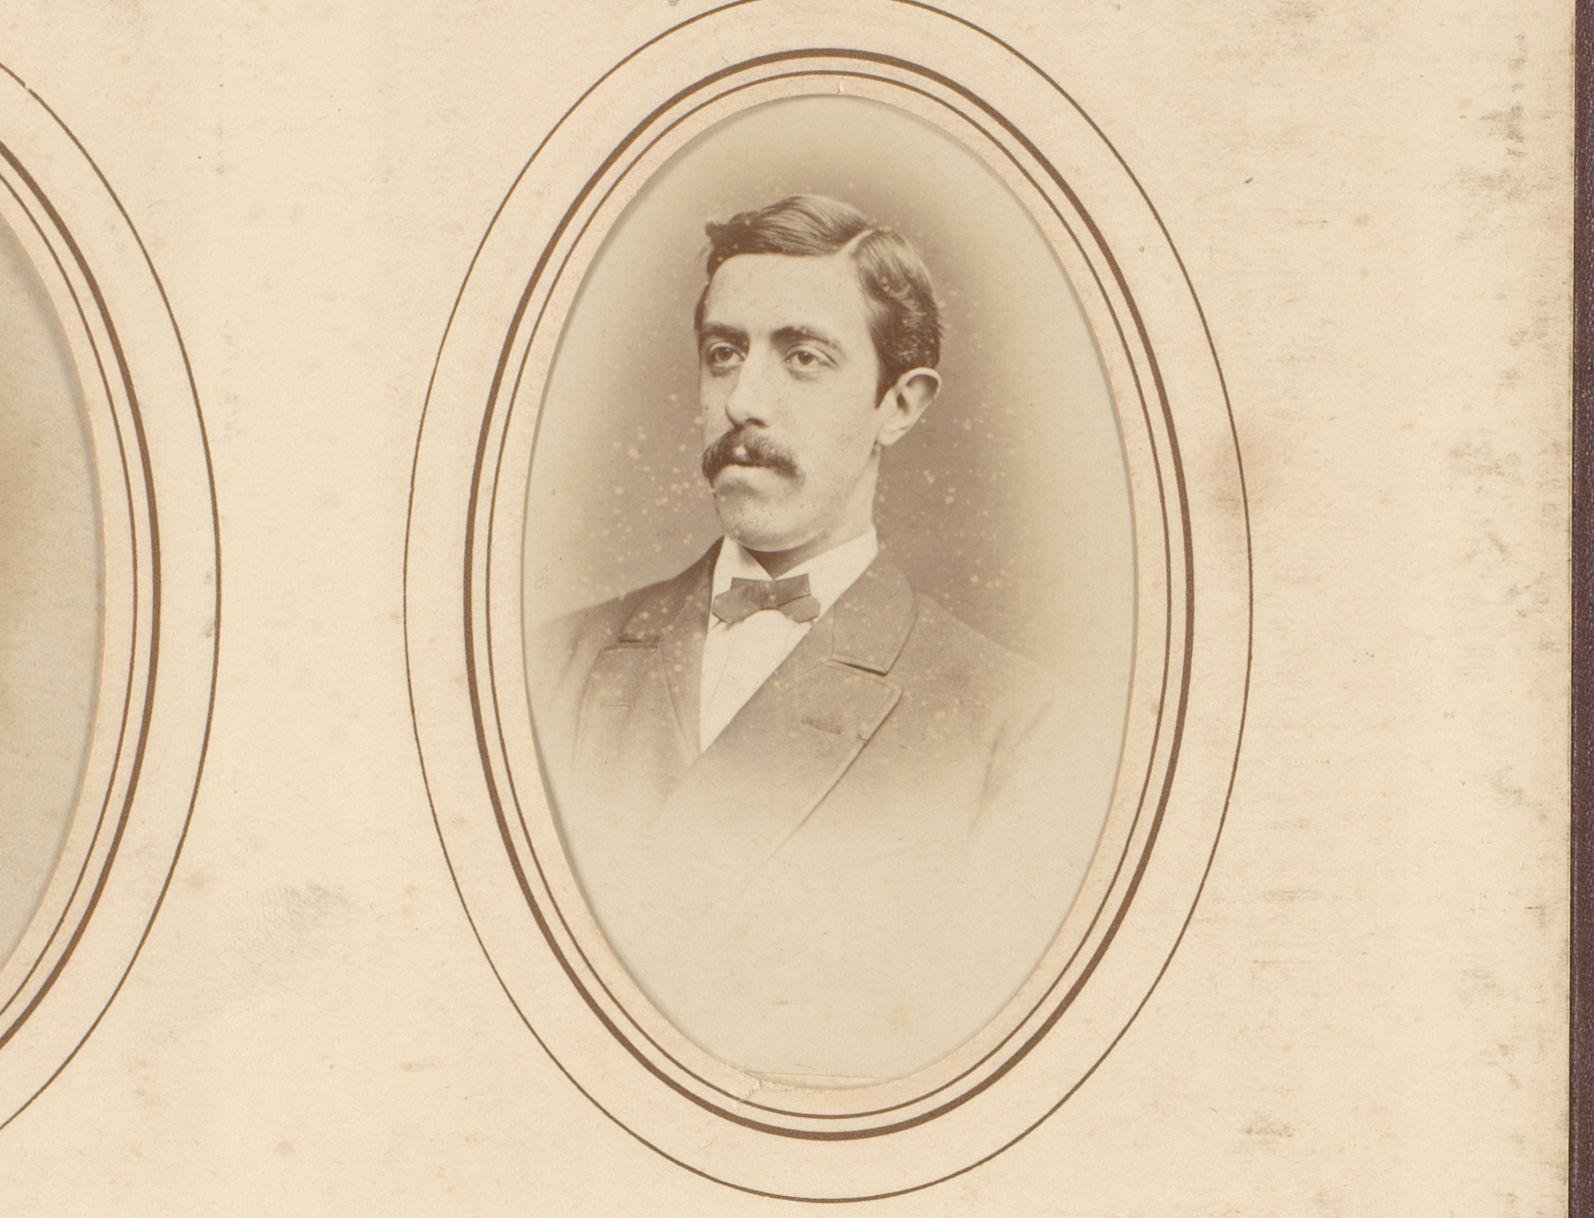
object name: album leaf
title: Portret van een man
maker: george lodewijk mulder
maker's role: fotograaf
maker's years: 1841-1920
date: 1860-1875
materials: cardboard, photographic support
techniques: albumen print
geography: utrecht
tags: adult man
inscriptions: inscription: ‘G.L. Mulder Utrecht.’, inscription: ‘G.L.M./ Photogr. Atelier/ G.L. Mulder/ van Wijckskade H. 326/ Utrecht’